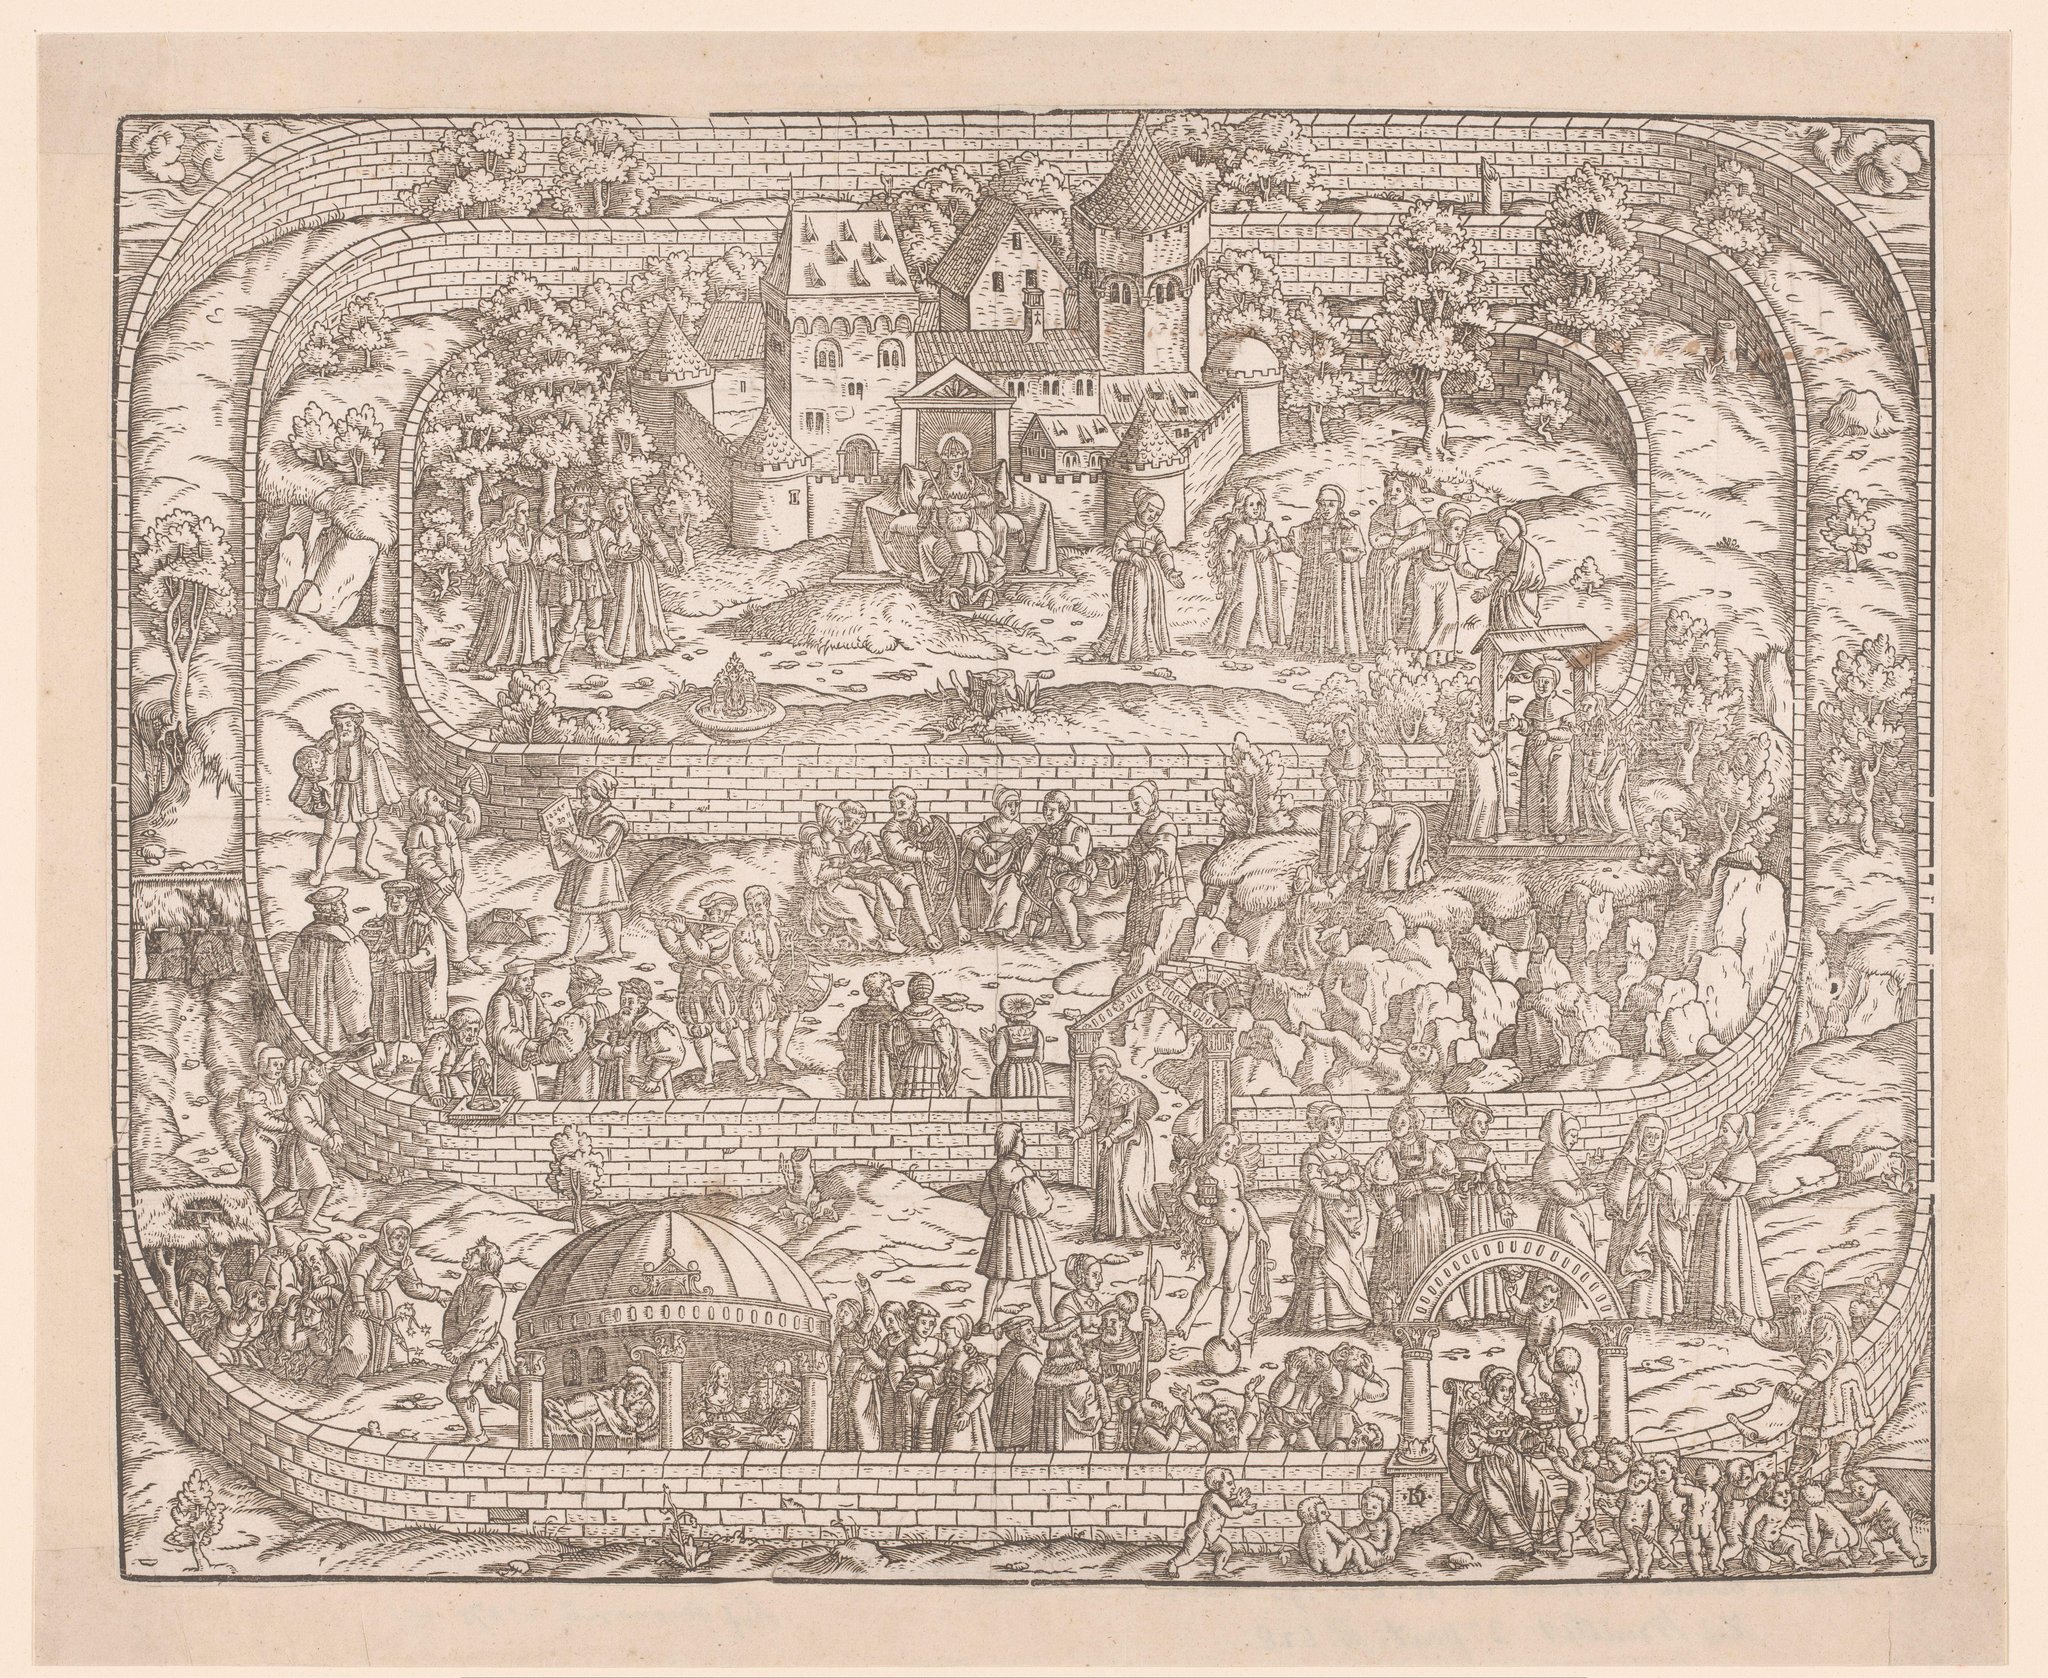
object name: print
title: Tabula Cebetis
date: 1560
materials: paper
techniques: woodcut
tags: 'tabula cebetis'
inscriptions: collector's mark: Lugt 240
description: Kasteel omringd door drie muren waarin zich verschillende gradaties van morele puurheid bevinden met in het centrum het hoogtepunt.